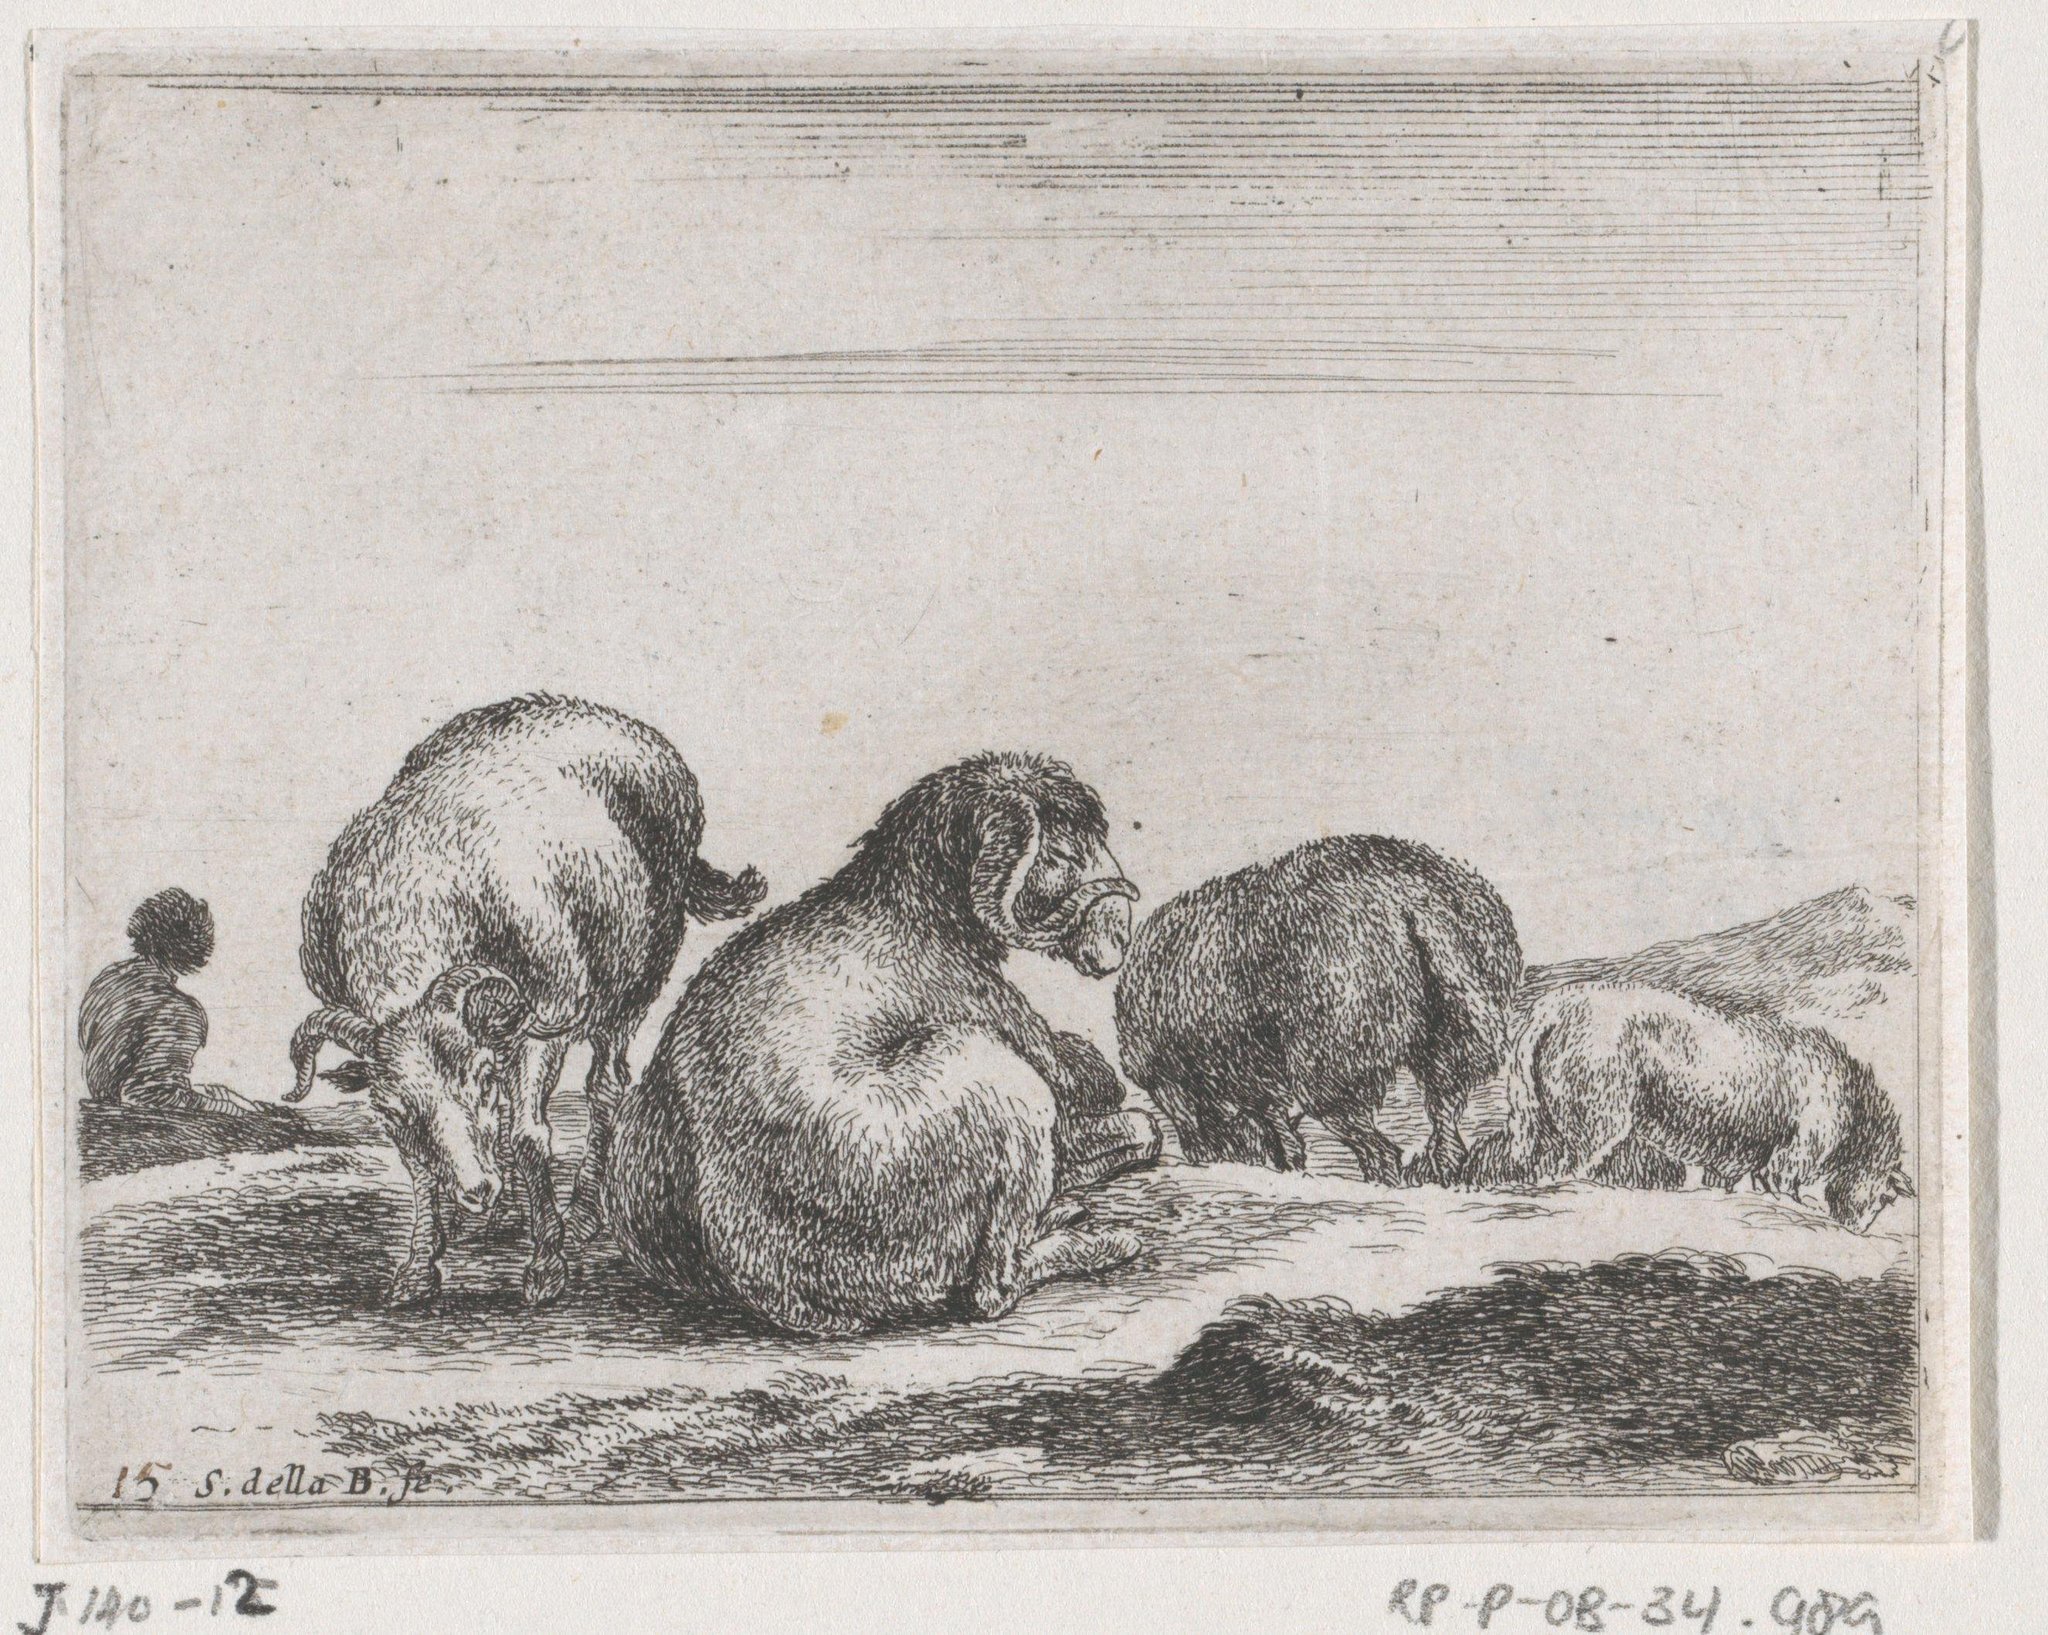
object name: print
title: Schapen en rammen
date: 1620-1664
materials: paper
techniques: etching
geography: france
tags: animals, herding, herdsman, herdswoman, shepherd, shepherdess, cowherd, etc., ram, goat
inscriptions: collector's mark: Lugt 240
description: Schapen en rammen in een landschap. Op de achtergrond links ligt een herder.